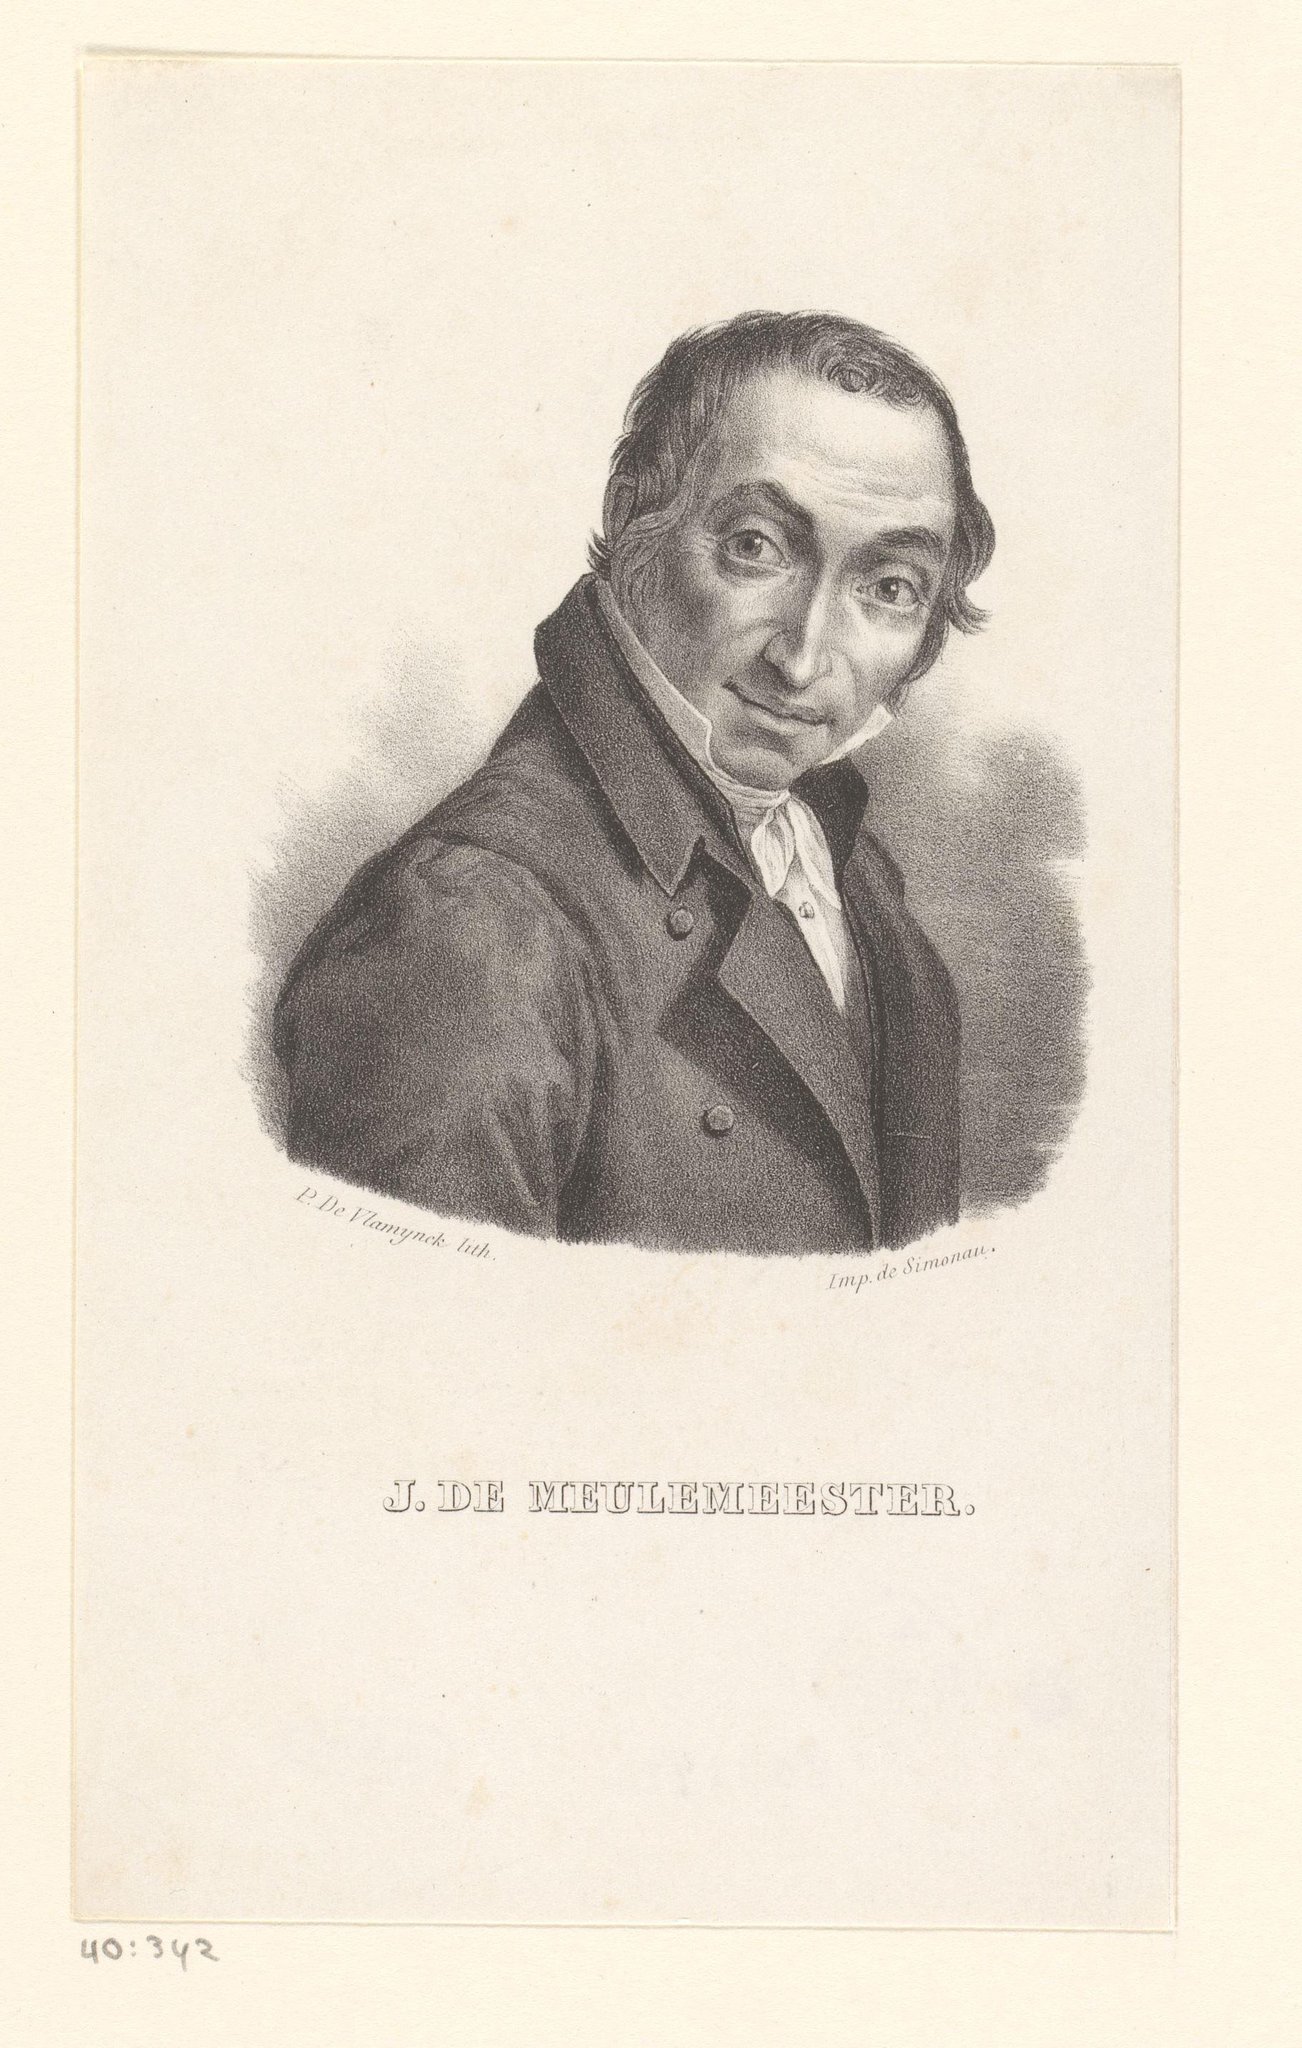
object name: print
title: J. de Meulemeester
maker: pieter jan de vlamynck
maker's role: print maker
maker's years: 1795-1850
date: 1805-1850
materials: paper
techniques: lithograph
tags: antwerp, print maker, jozef karel de meulemeester, adult man, historical persons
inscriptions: collector's mark: Lugt 2760, collector's mark: Lugt 2228